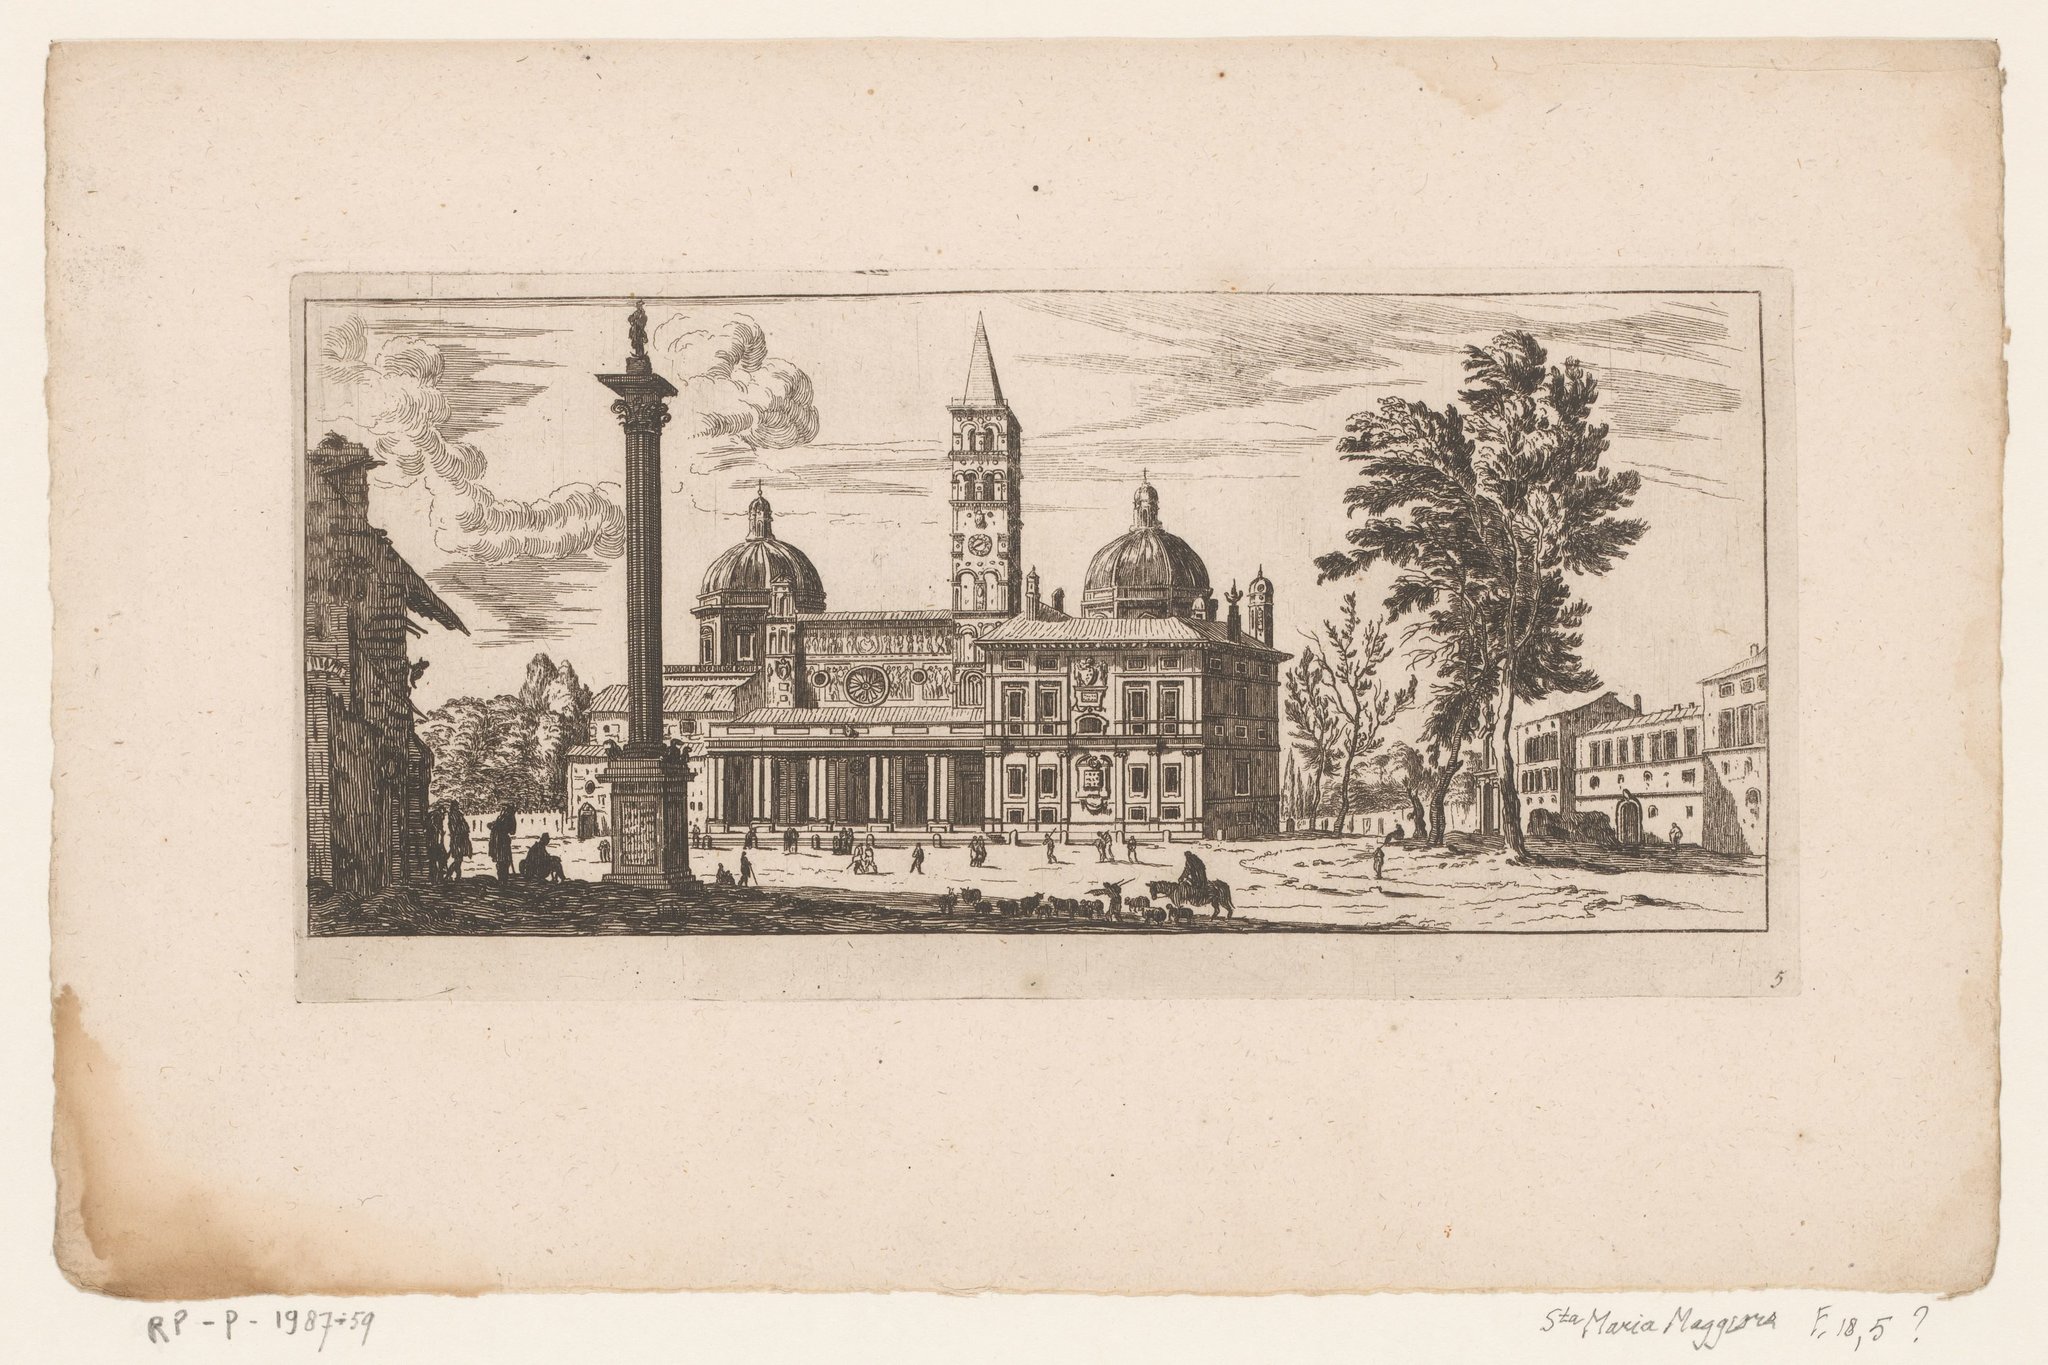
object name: print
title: Gezicht op de Santa Maria Maggiore, te Rome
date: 1648-1712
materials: paper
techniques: etching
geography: amsterdam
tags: church (exterior)